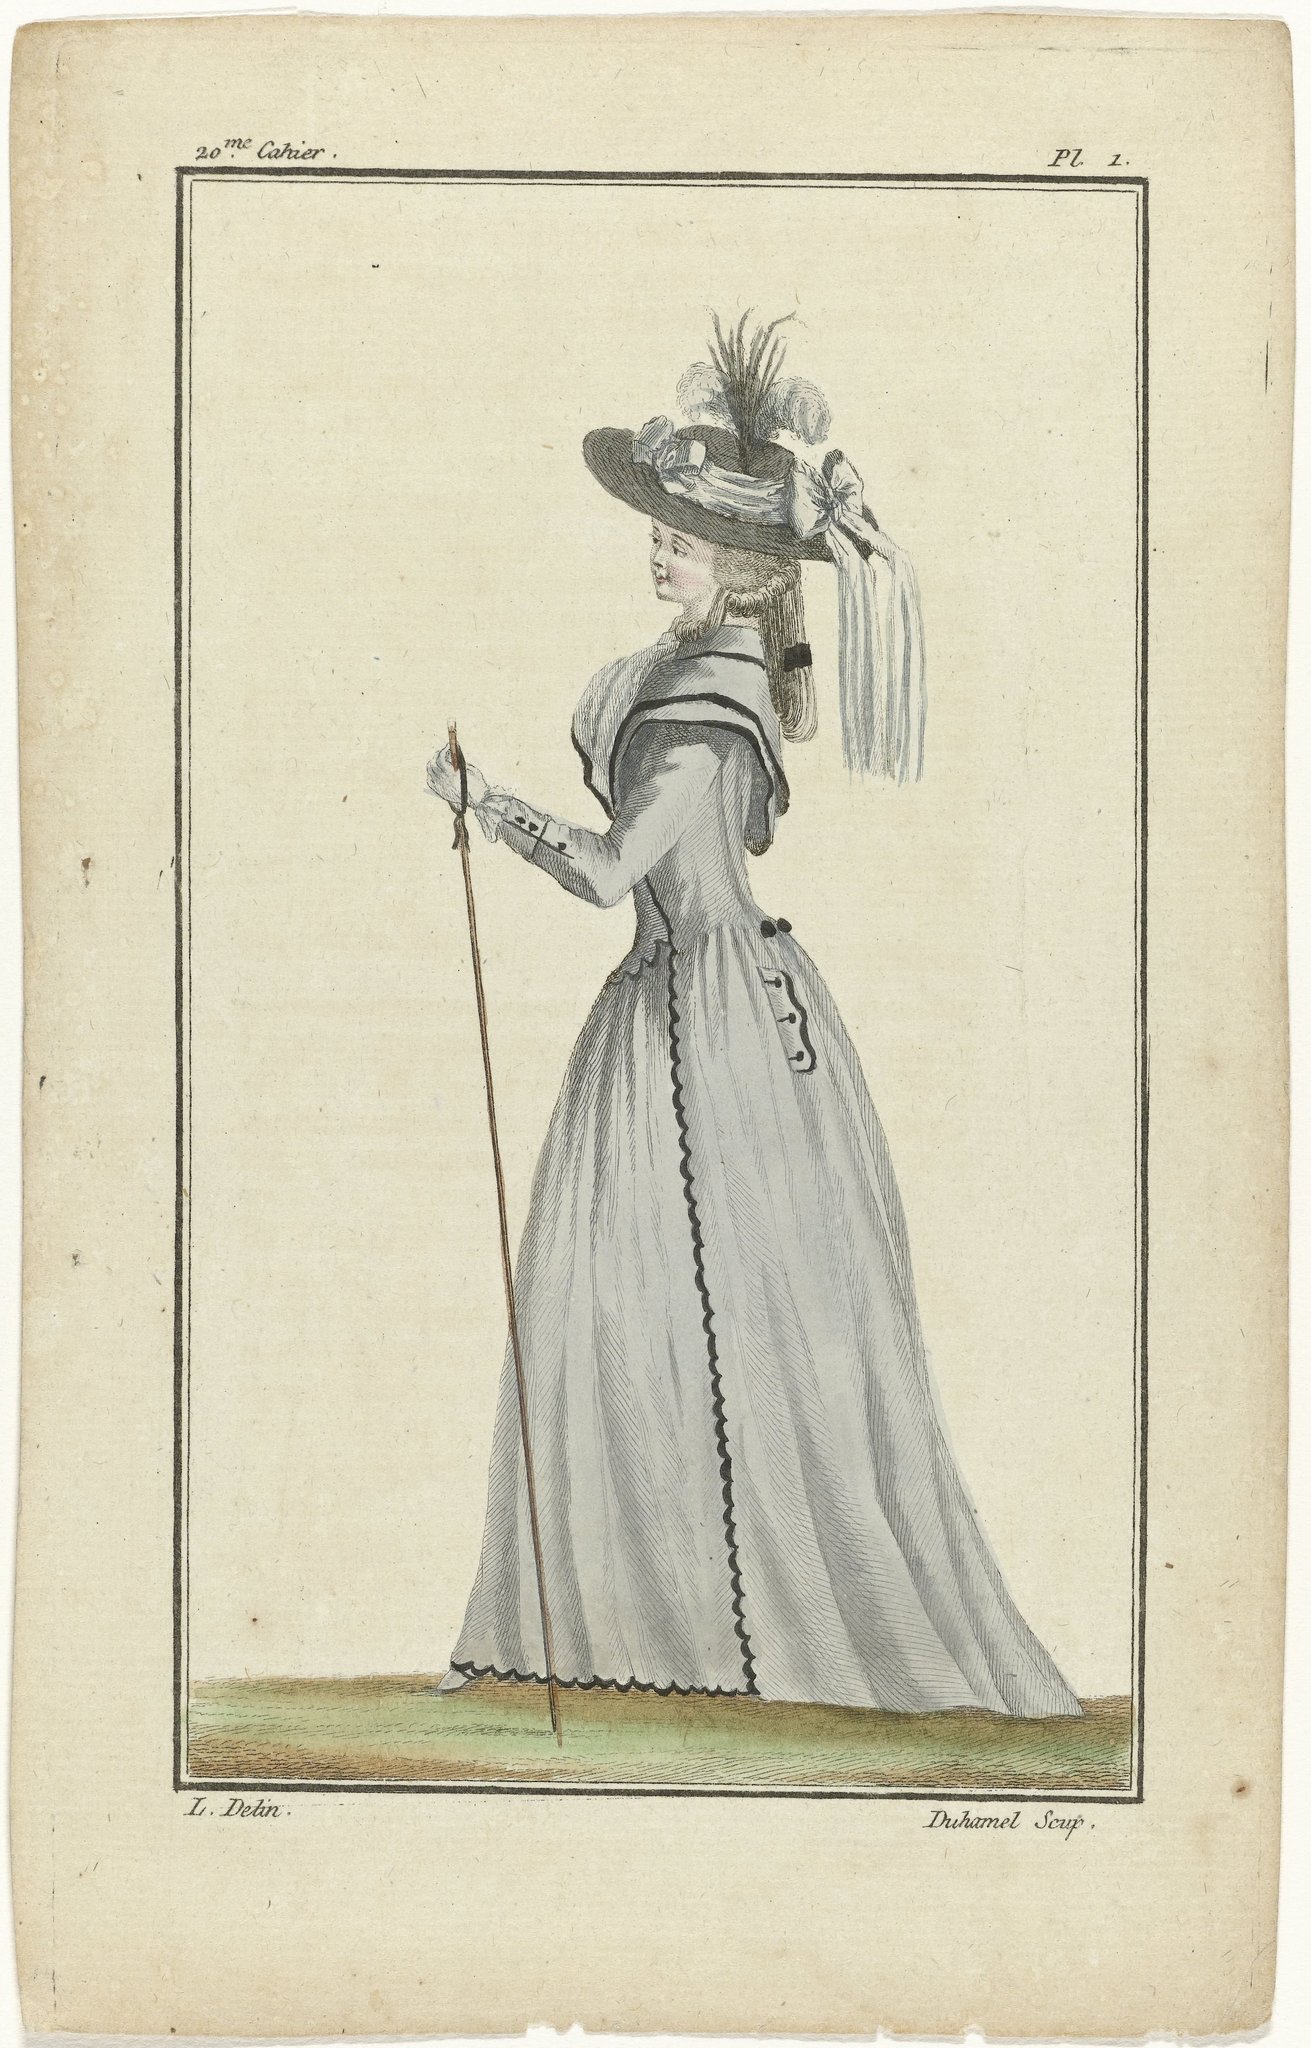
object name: fashion print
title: Fashion News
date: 1786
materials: paper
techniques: engraving, hand coloring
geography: paris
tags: walking-stick, staff, cane (+ women's clothes), dress, gown: redingote (+ women's clothes), head-gear (straw hat) (+ women's clothes), neck-gear: collar (+ women's clothes), fashion plates, skirt (+ women's clothes), gloves, mittens, etc. (+ women's clothes), mourning dress, piece of clothing covering the breast or décolleté (fichu) (+ women's clothes)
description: The Cabinet des Modes offered readers highly detailed information about the illustrated clothes and accessories. It reported, for instance, on new clothing styles, such as the English ‘redingote’ 1; on accessories and embellishments, such as oversized muffs, buttons, ribbons and clasps; and finally, on the latest interior furnishings. For its male audience there was the fitted jacket 2 and the popular Androsmane, a hat with an upturned brim 3.